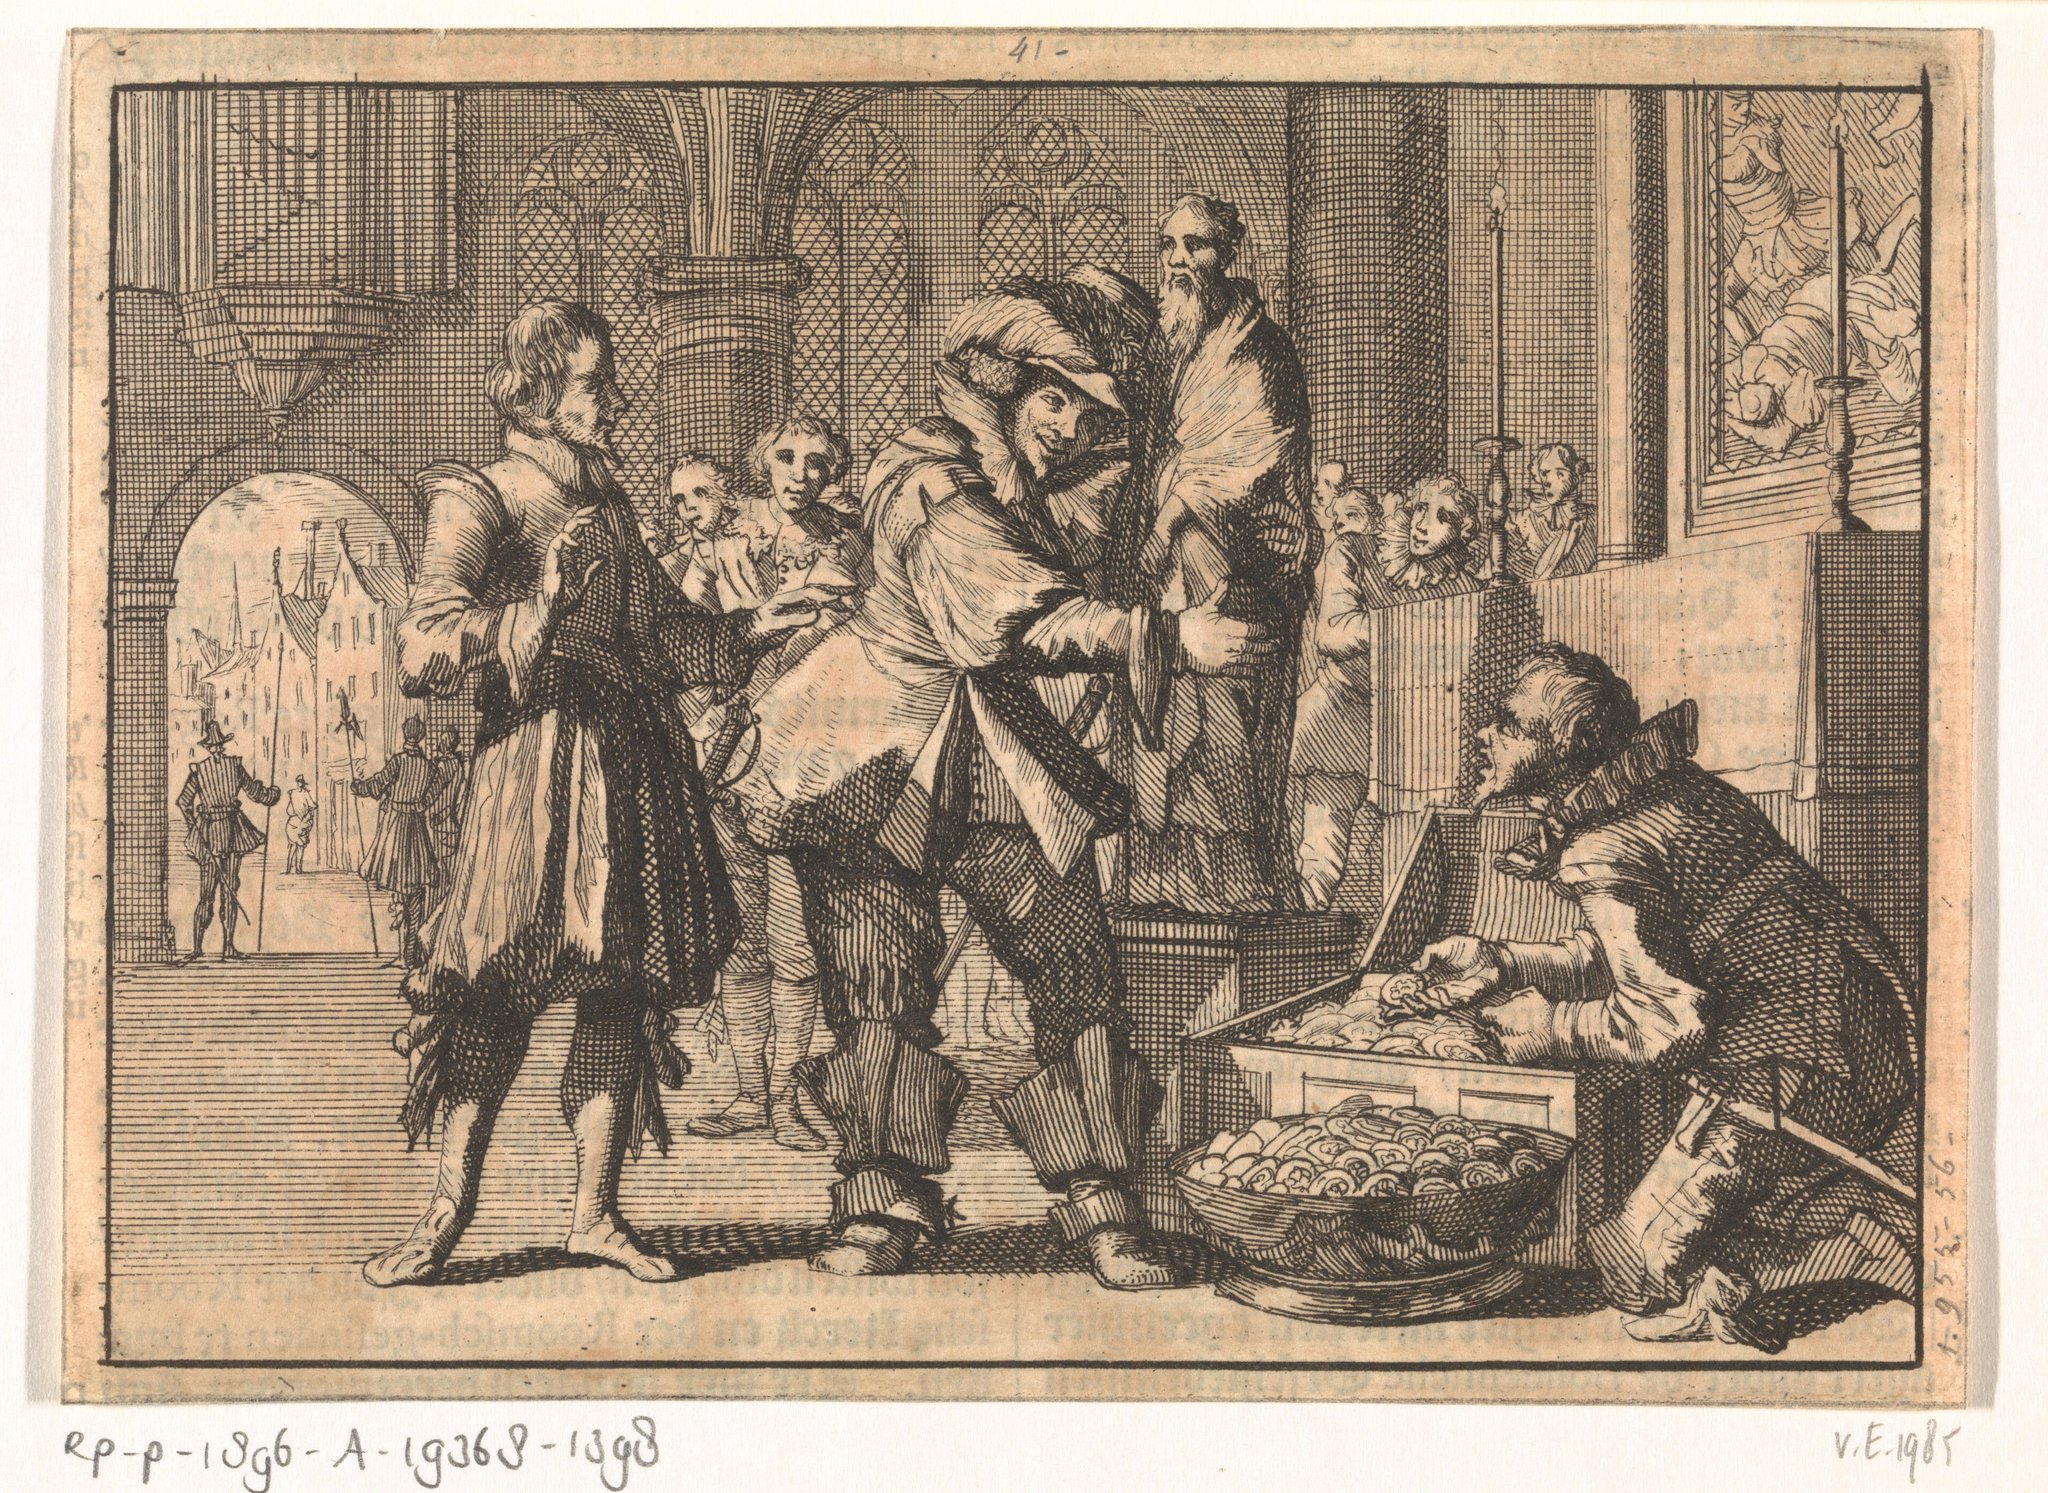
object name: book illustration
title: Christiaan, hertog van Brunswijk, vindt in de Dom van het door hem veroverde Paderborn schatten waaronder het gouden beeld van Liborius, 1622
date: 1698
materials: paper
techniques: etching, letterpress printing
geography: amsterdam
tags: monument, statue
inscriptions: collector's mark: Lugt 2228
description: Illustratie uit: Gottfried, Johann Ludwig. Historische kronyck; vervattende een (...) beschrijvingh der aldergedenckwaerdigste geschiedenissen des weerelds, van den aenvangh der scheppingh tot (...) 1576 (2 delen). Leiden: Pieter van der Aa, 1698, dl. I, p. 955.